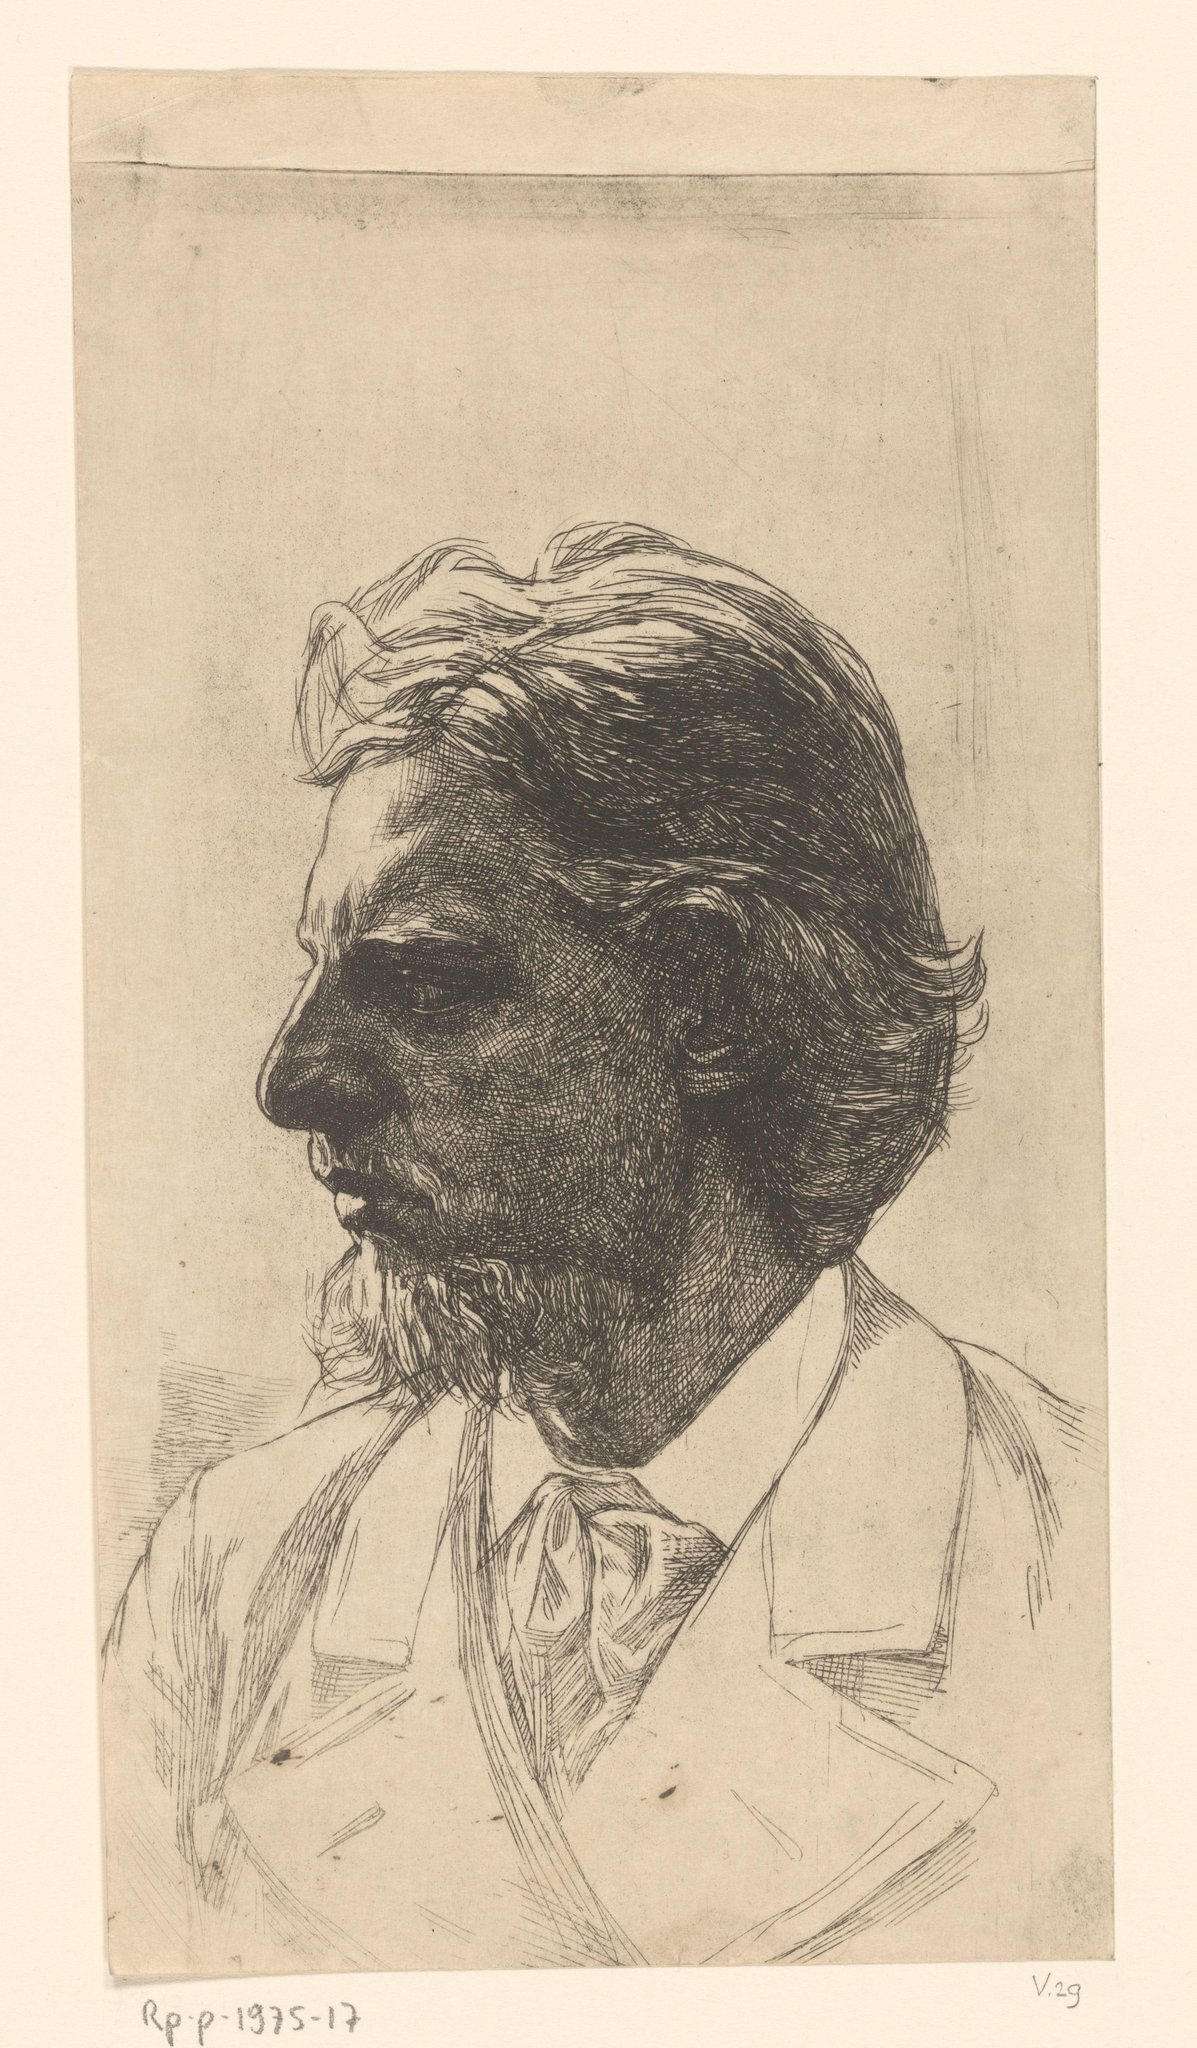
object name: print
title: Portret van Jacques Perk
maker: jan veth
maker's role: designer, draughtsman, painter, print maker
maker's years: 1864-1925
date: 1887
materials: paper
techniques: etching, intaglio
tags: jacques perk, historical persons, writer, poet, author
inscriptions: collector's mark: Lugt 2228